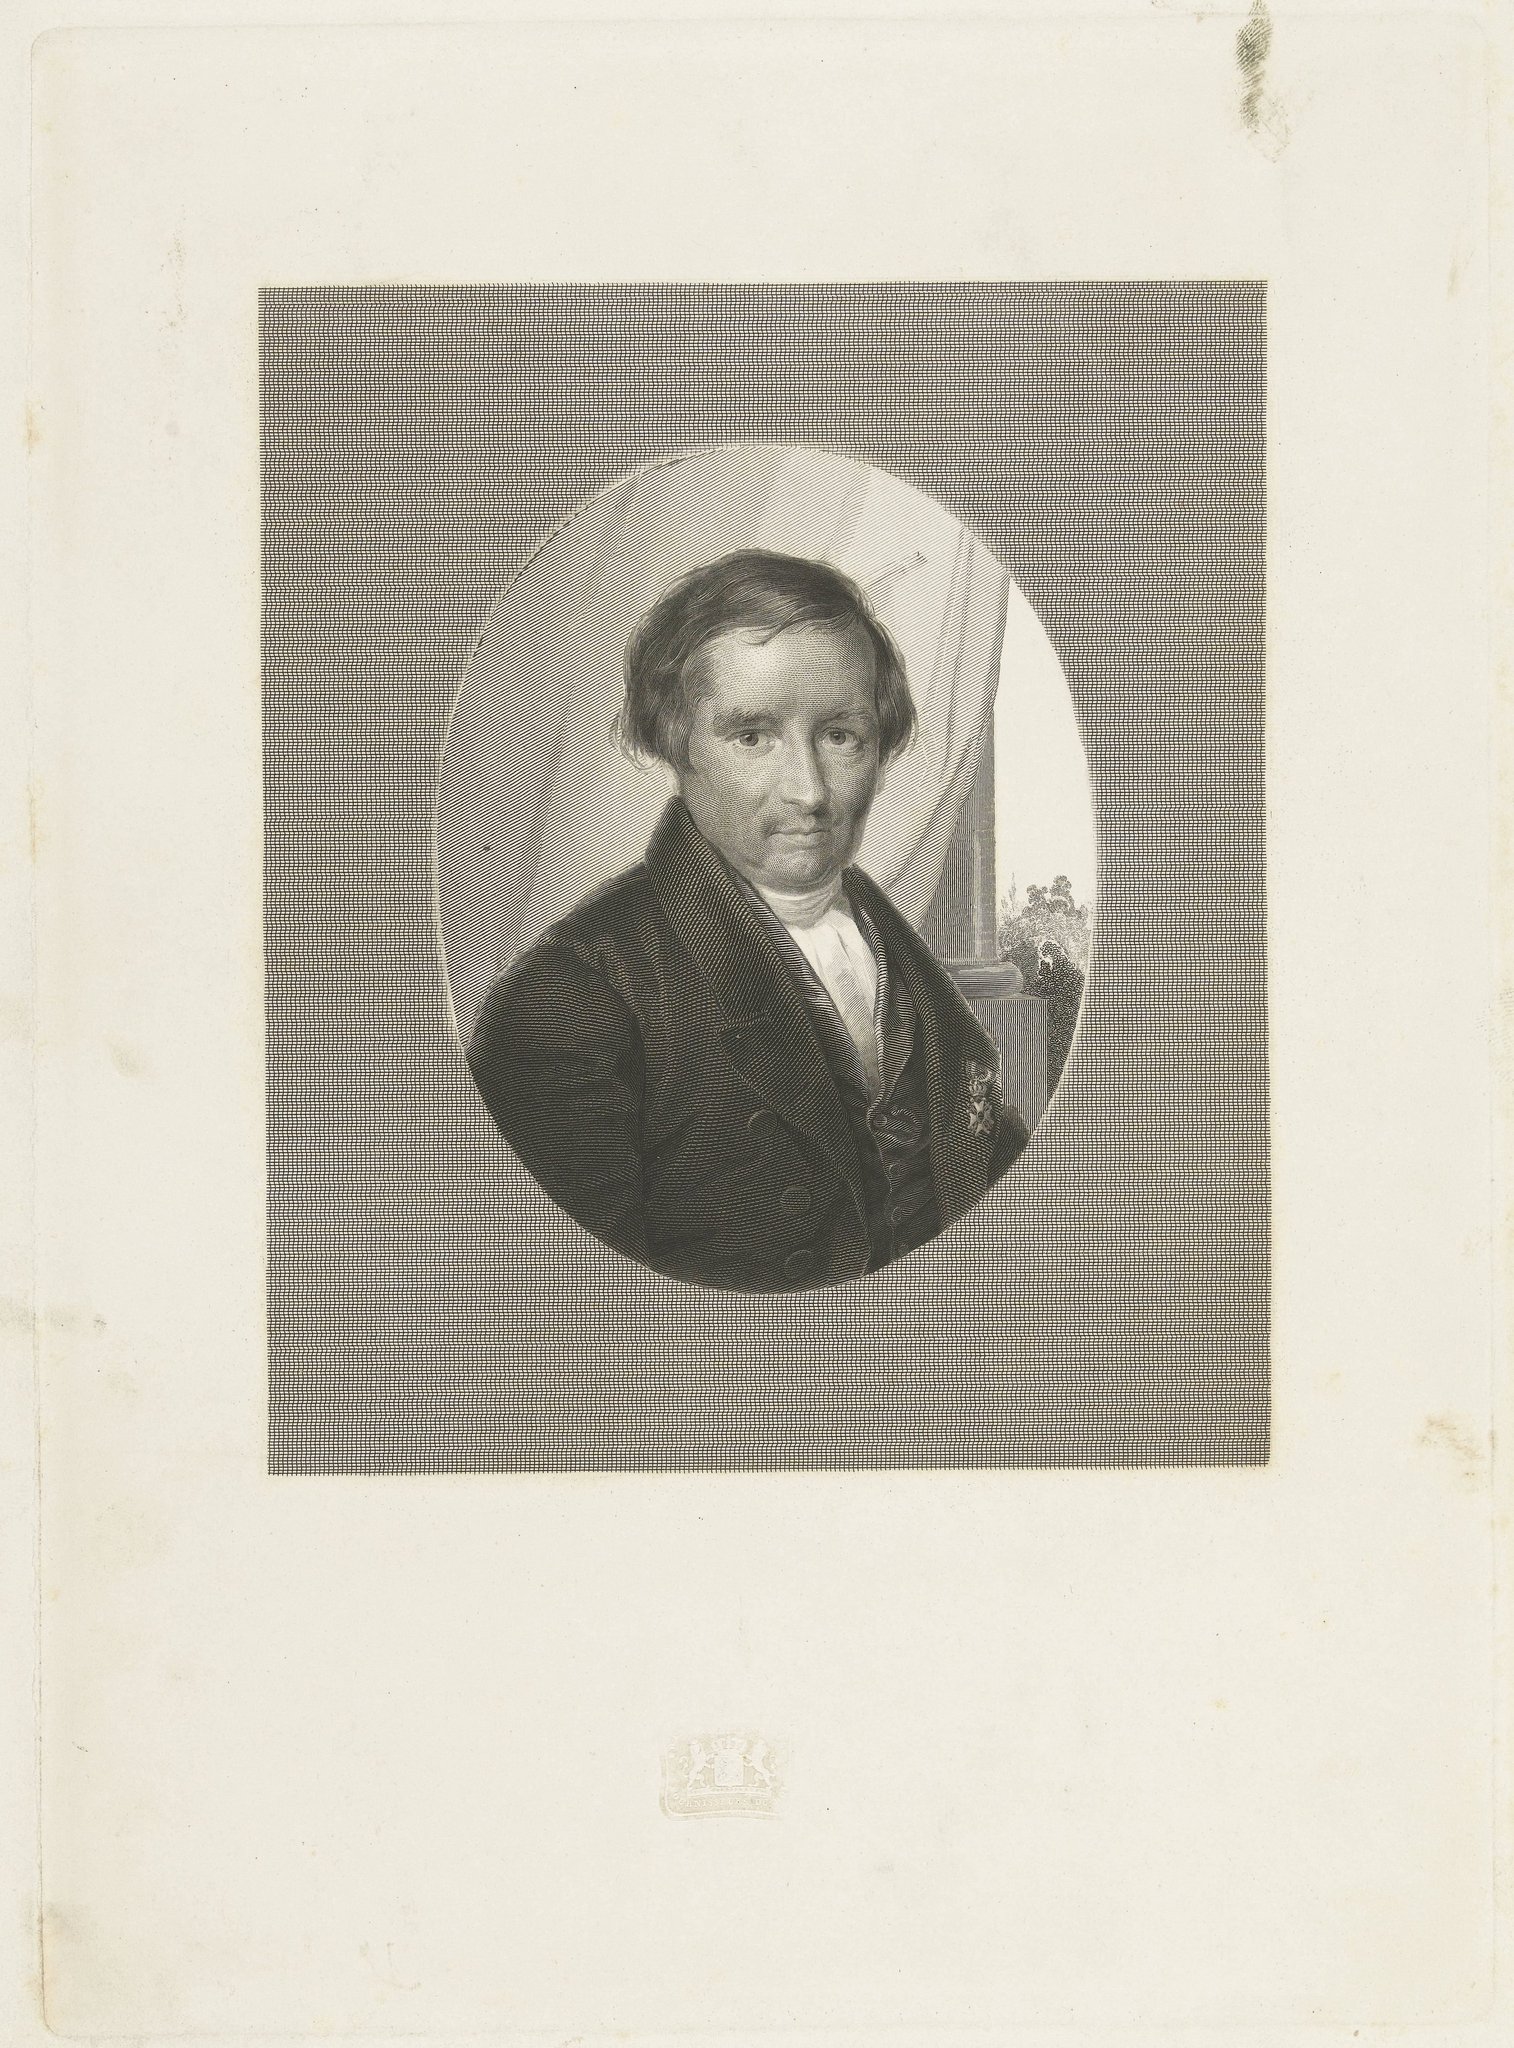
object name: print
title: Portret van Willem de Clercq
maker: henricus wilhelmus couwenberg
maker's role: draughtsman, print maker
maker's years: 1814-1845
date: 1829-1845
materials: paper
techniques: engraving, etching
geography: amsterdam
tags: amsterdam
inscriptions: collector's mark: Lugt 2228, check stamp: ‘Uitgeversstempel Frans Buffa en Zonen, Amsterdam’